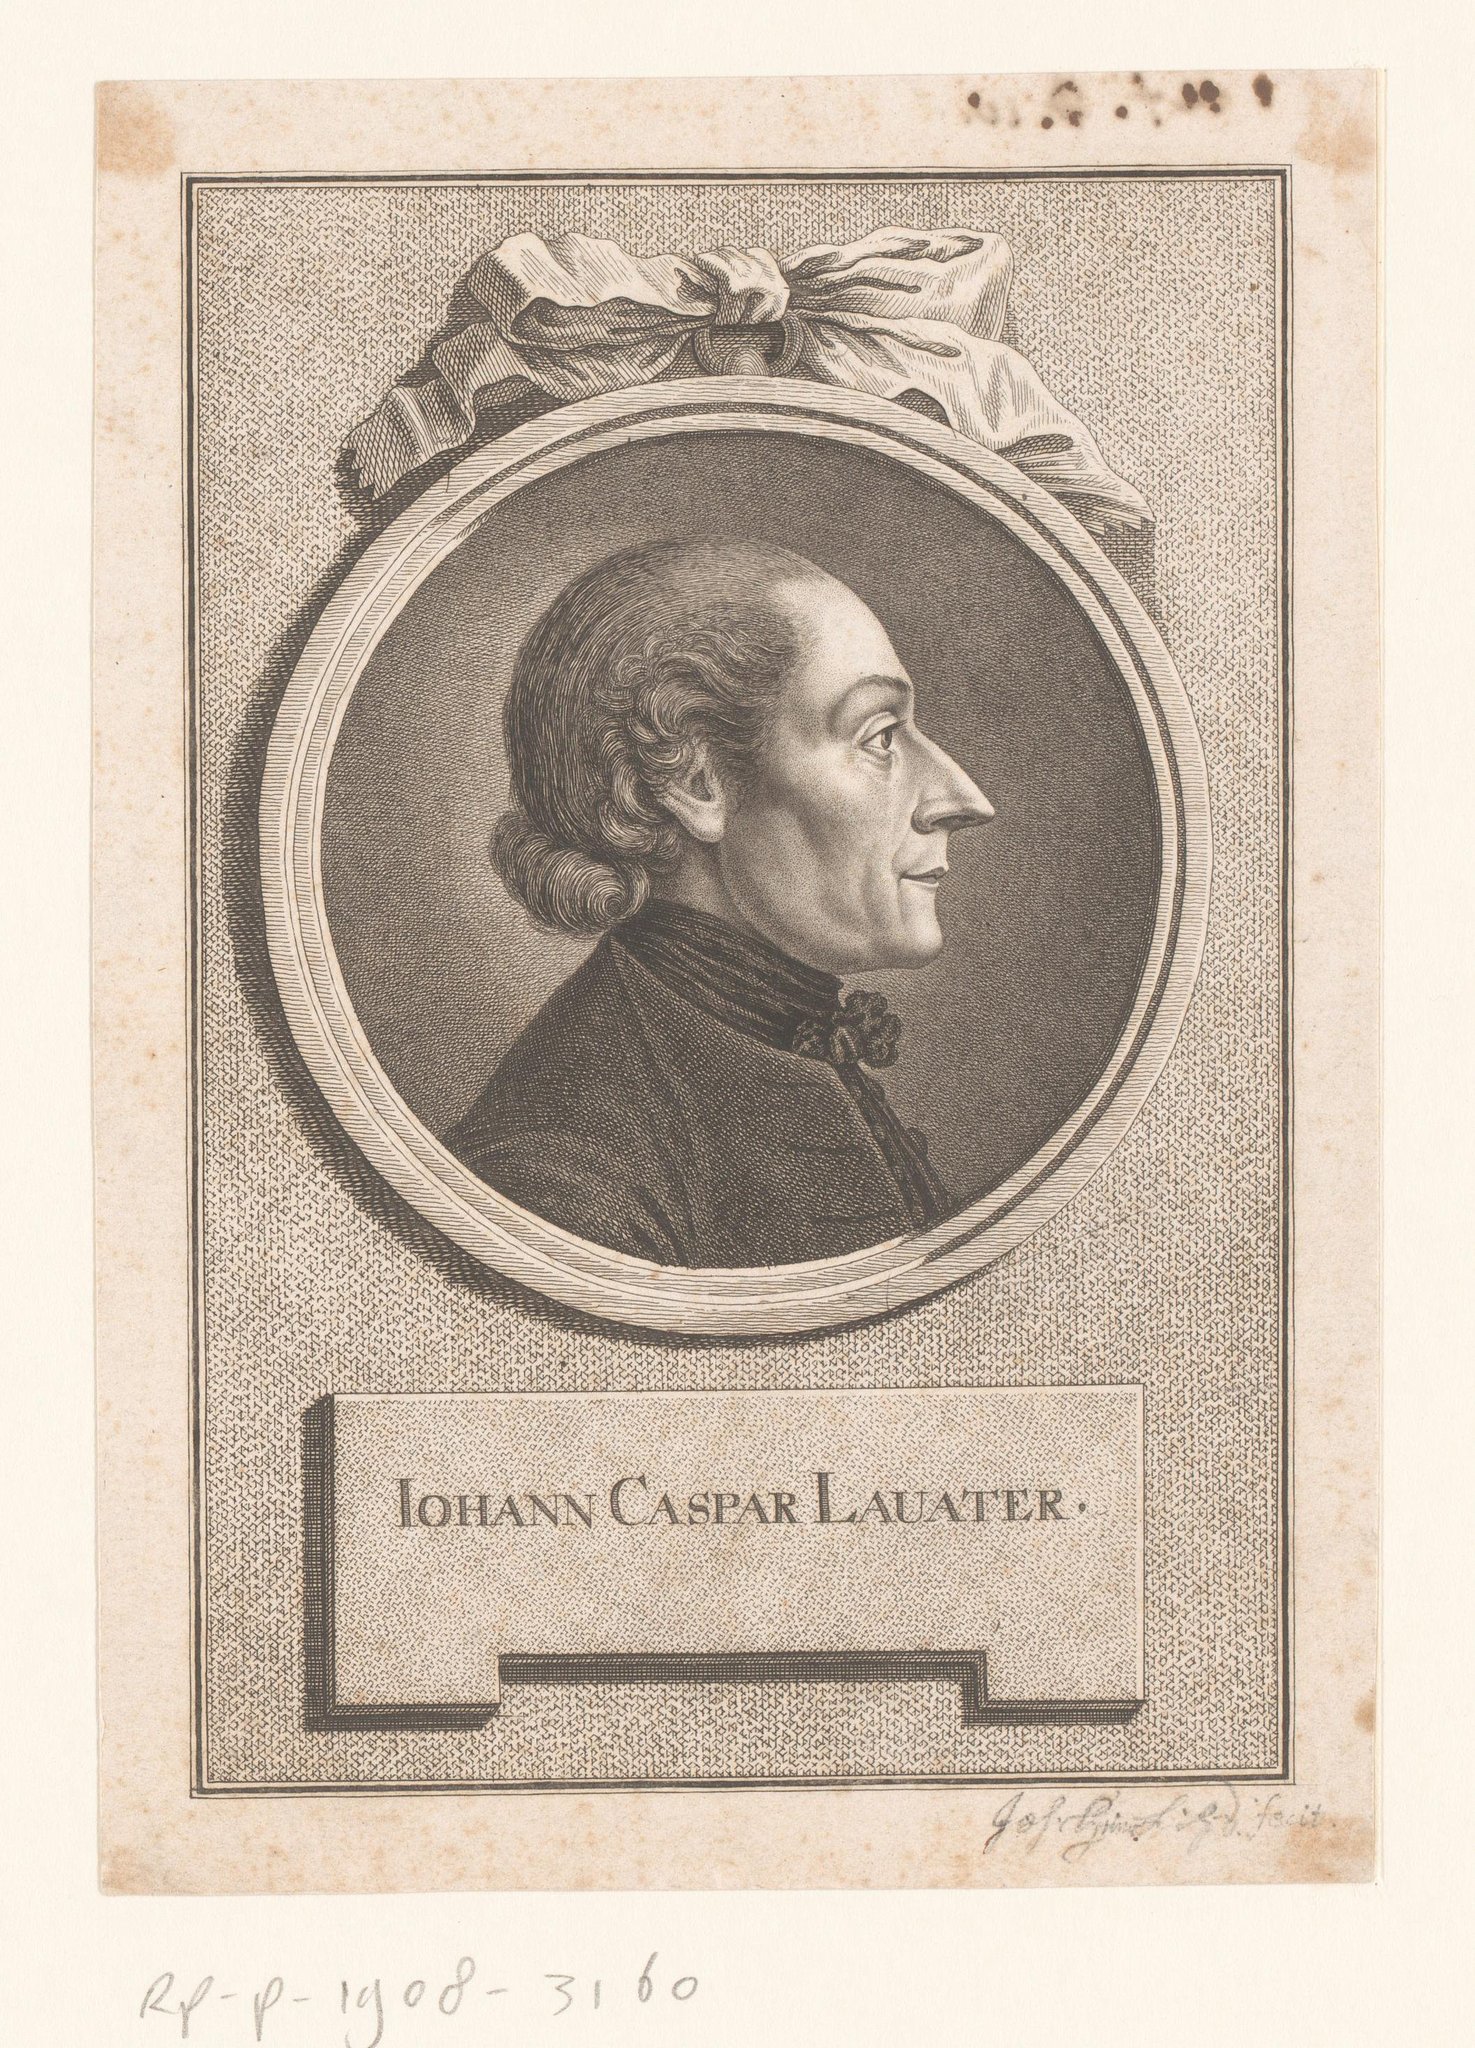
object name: print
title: Portret van Johann Caspar Lavater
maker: georg friedrich schmoll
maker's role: draughtsman, print maker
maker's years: 1700-1785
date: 1700-1785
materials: paper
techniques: etching, engraving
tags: johann caspar lavater, historical persons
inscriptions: collector's mark: Lugt 2228